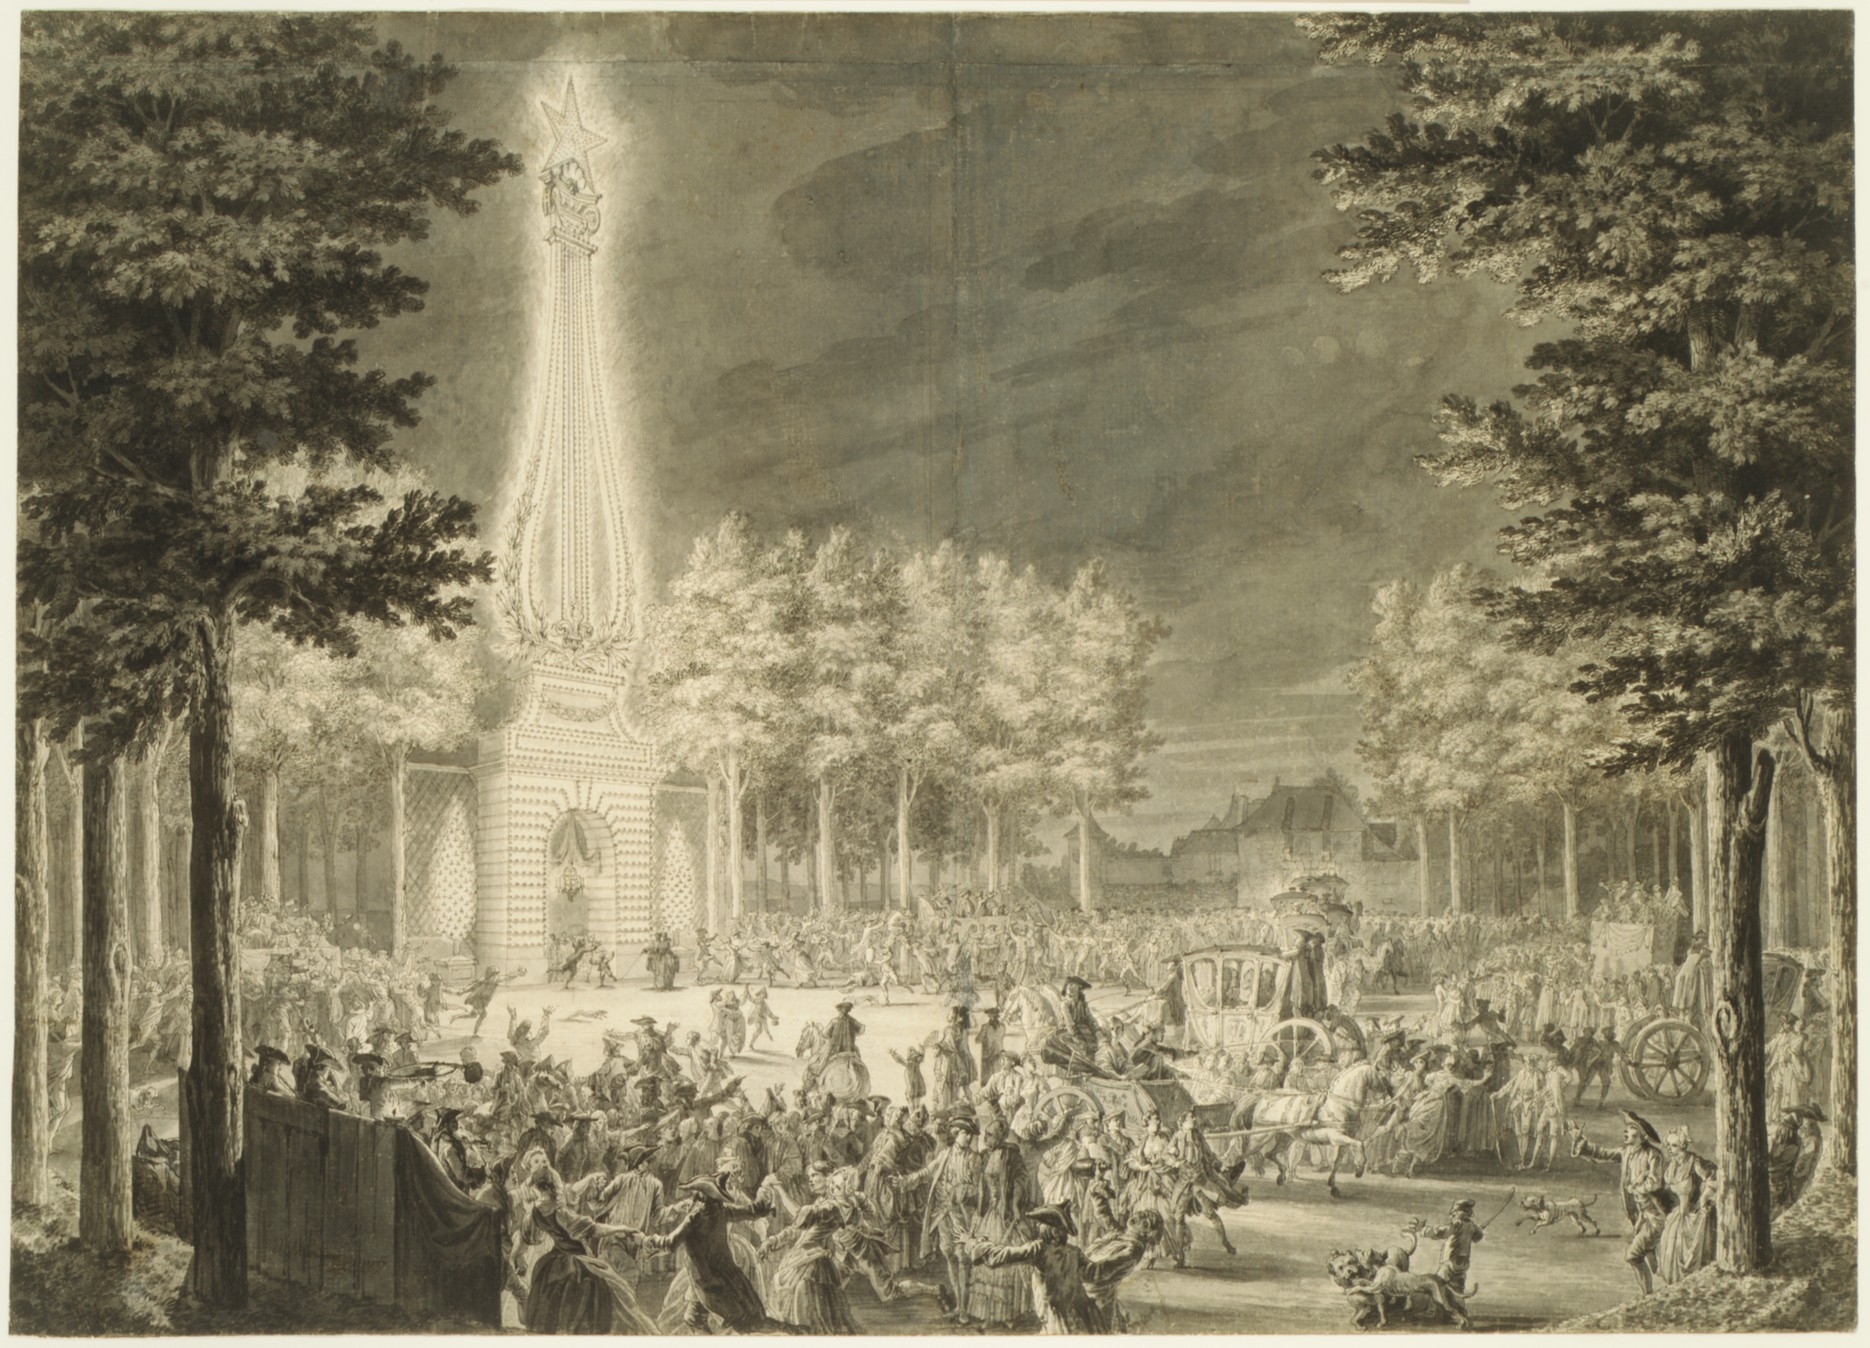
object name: drawing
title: Design for the Engraving "Réjouissances du Peuple . . . à Reims le 27 aout 1765"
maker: jean michel moreau le jeune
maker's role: artist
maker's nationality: french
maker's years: 1741-1814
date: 1767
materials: ink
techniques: brush, pen, wash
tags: monuments,dancing,dogs,crowd